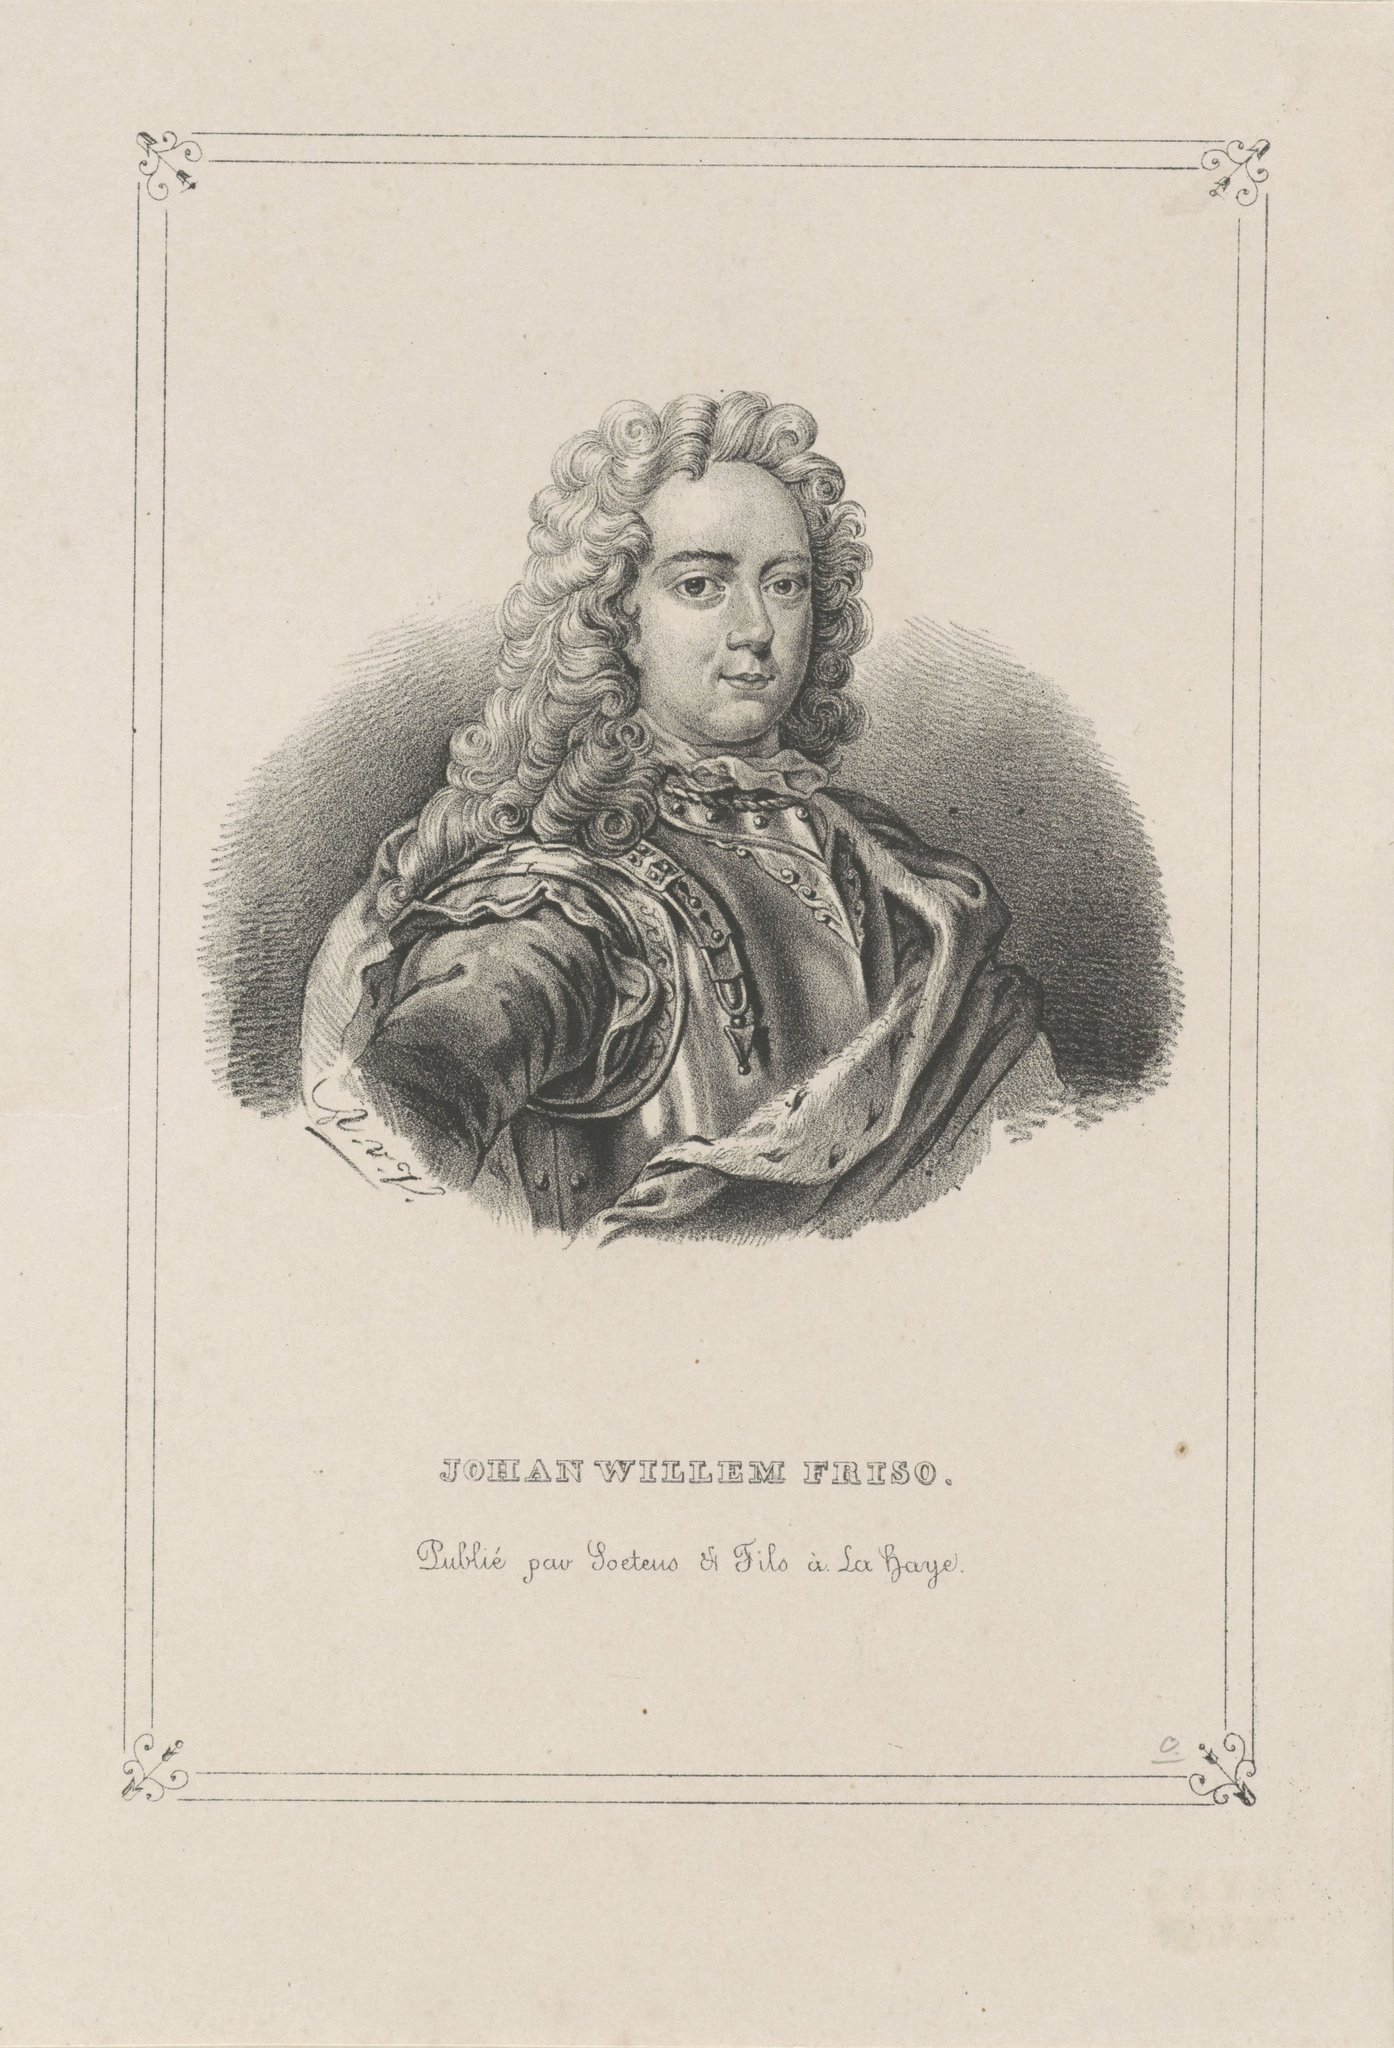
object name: print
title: Portret van Johan Willem Friso, prins van Oranje-Nassau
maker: anthonie van volkom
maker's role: print maker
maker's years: 1821-1860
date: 1837-1840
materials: paper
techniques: lithograph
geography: the hague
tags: johan willem friso (prins van oranje-nassau)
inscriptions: collector's mark: Lugt 2165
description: De hier vermelde titel verwijst naar de hoogst verkregen titel van de geportretteerde, niet per se naar de titel die de geportretteerde op deze voorstelling draagt.